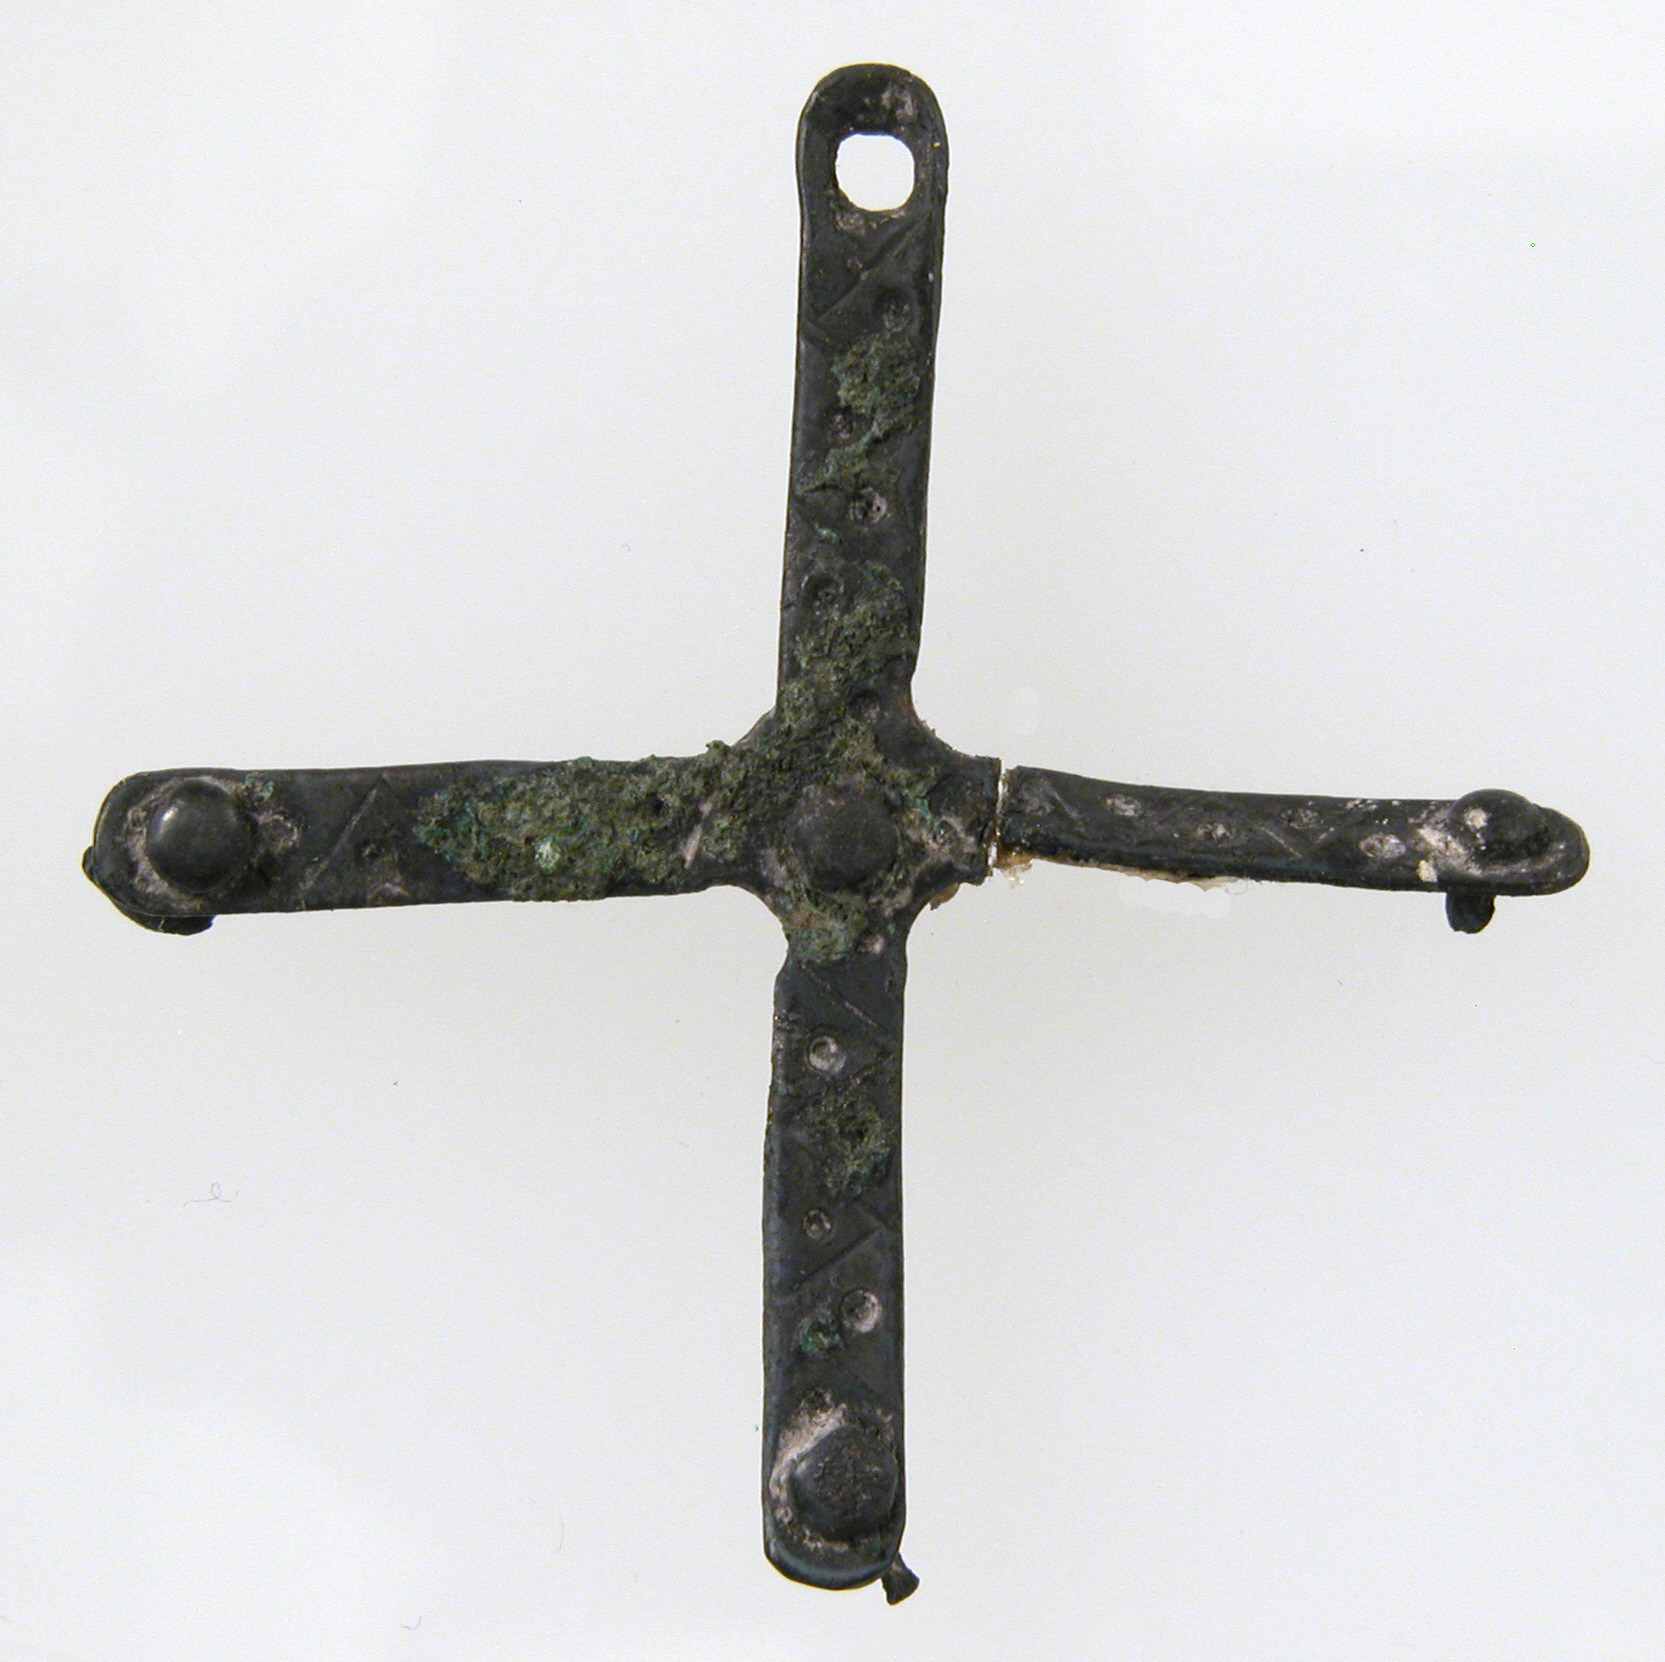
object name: cross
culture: roman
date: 601-700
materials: silver